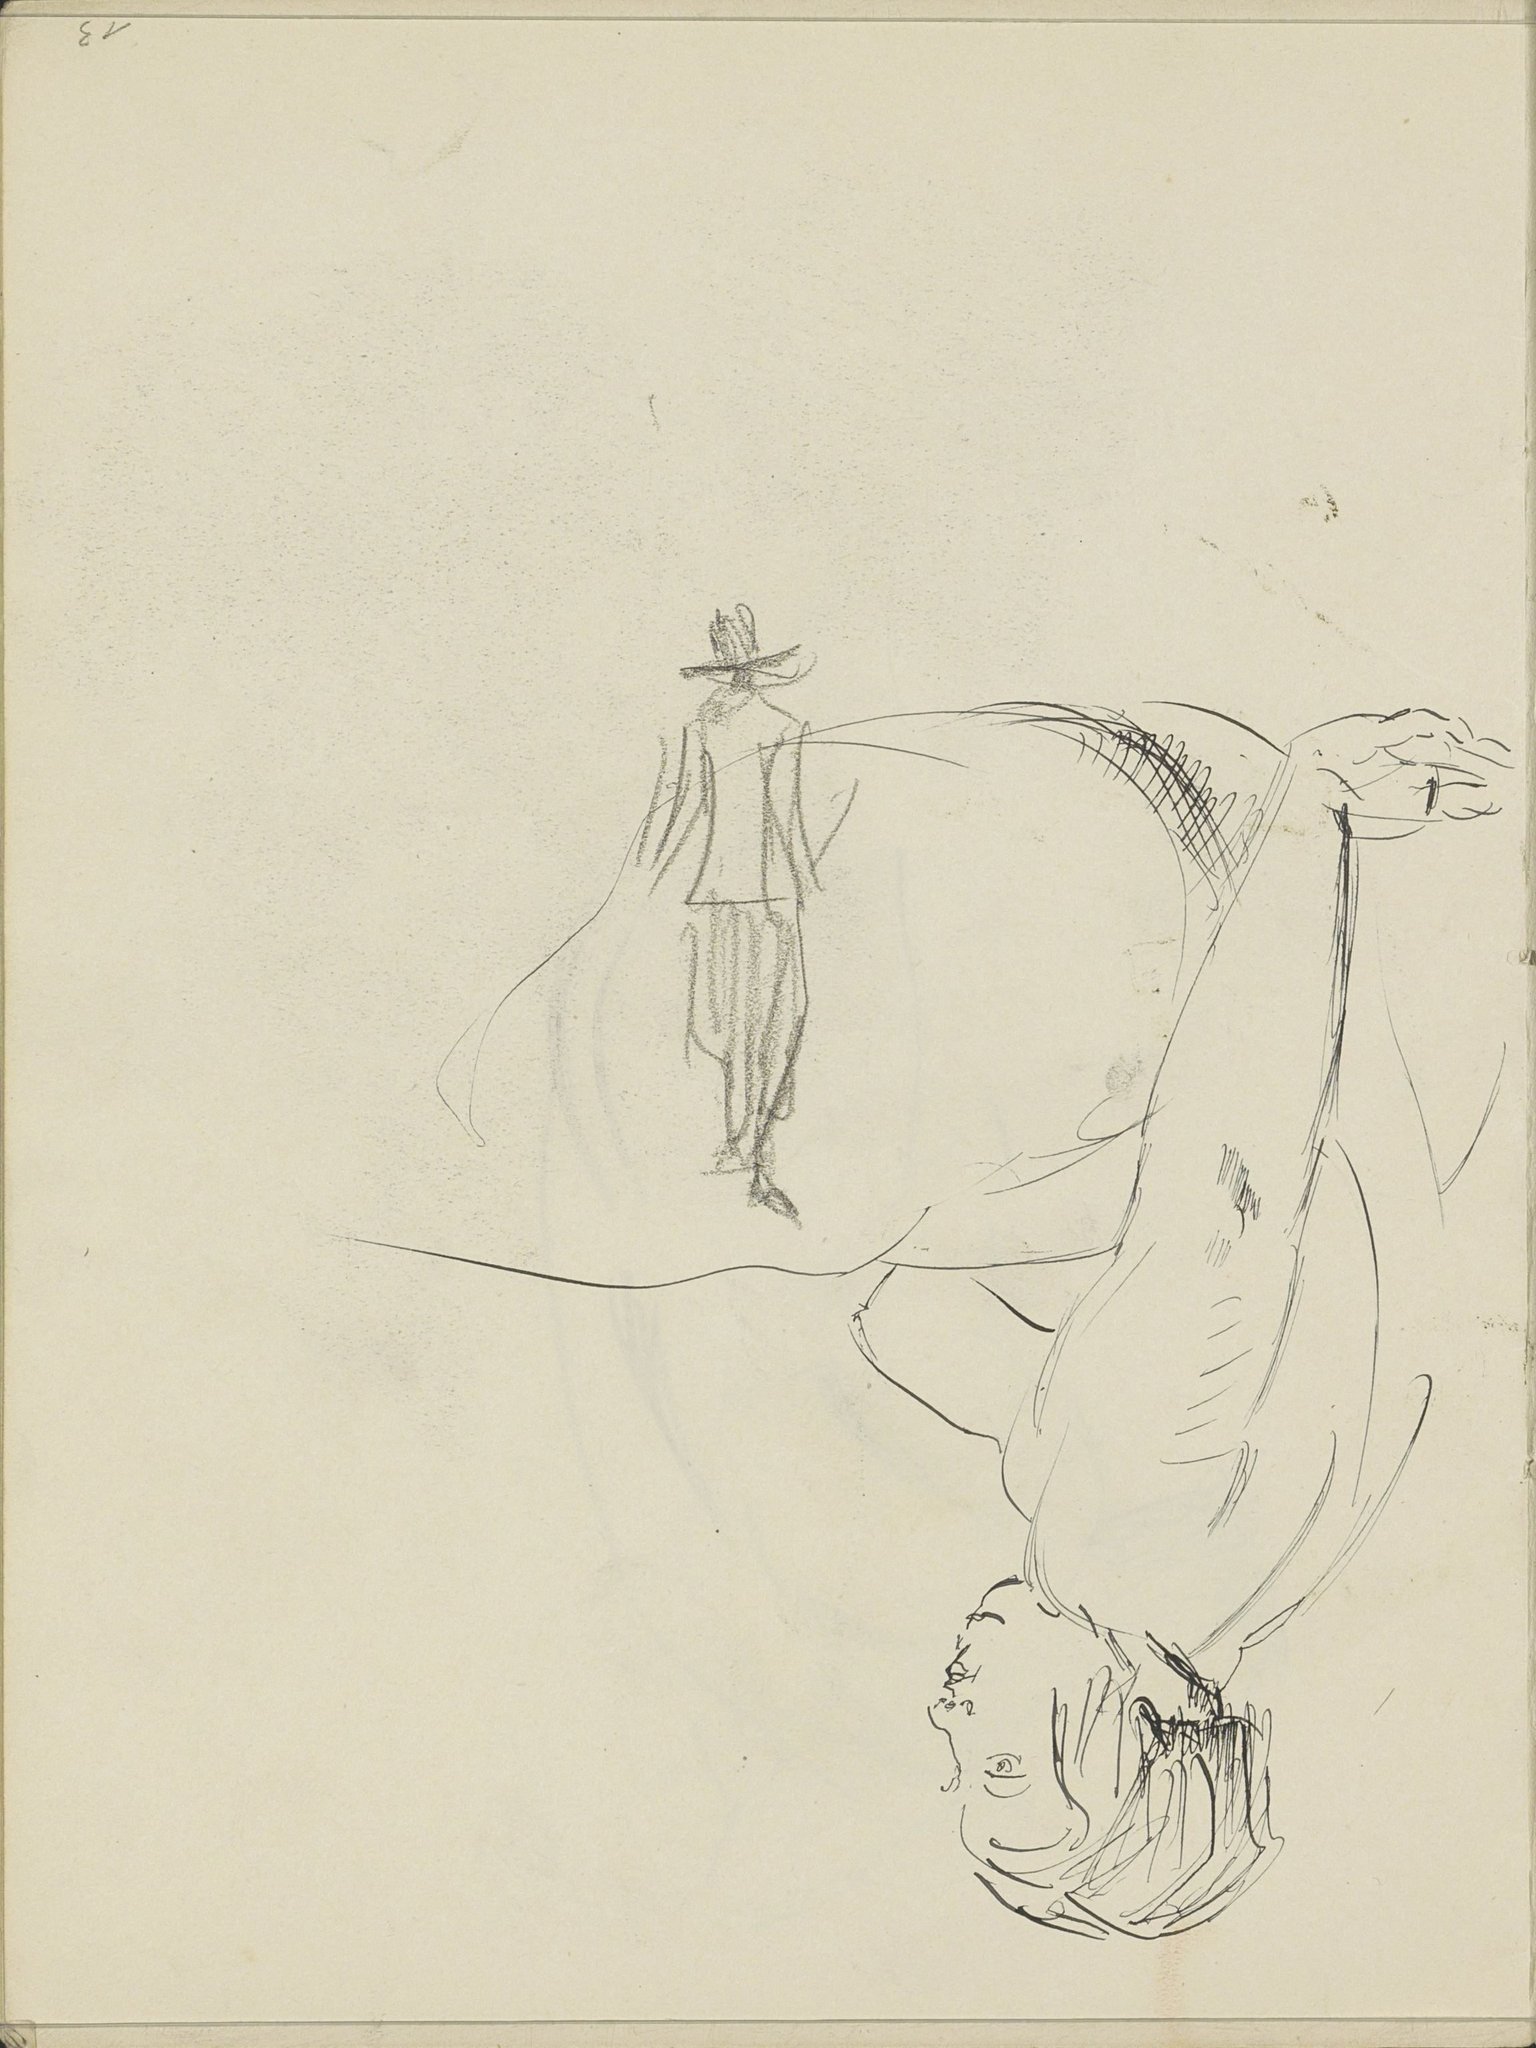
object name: sketchbook leaf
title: Zittend vrouwelijk naakt en een staande vrouw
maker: isaac israels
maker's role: draughtsman, painter, print maker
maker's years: 1865-1934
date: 1875-1934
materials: chalk, ink, paper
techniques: pen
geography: the hague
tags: the (nude) human figure; 'corpo humano' (ripa) - aa - female human figure (+ sitting), adult woman (+ standing)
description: Blad 8 verso uit schetsboek XXIV met 10 bladen.